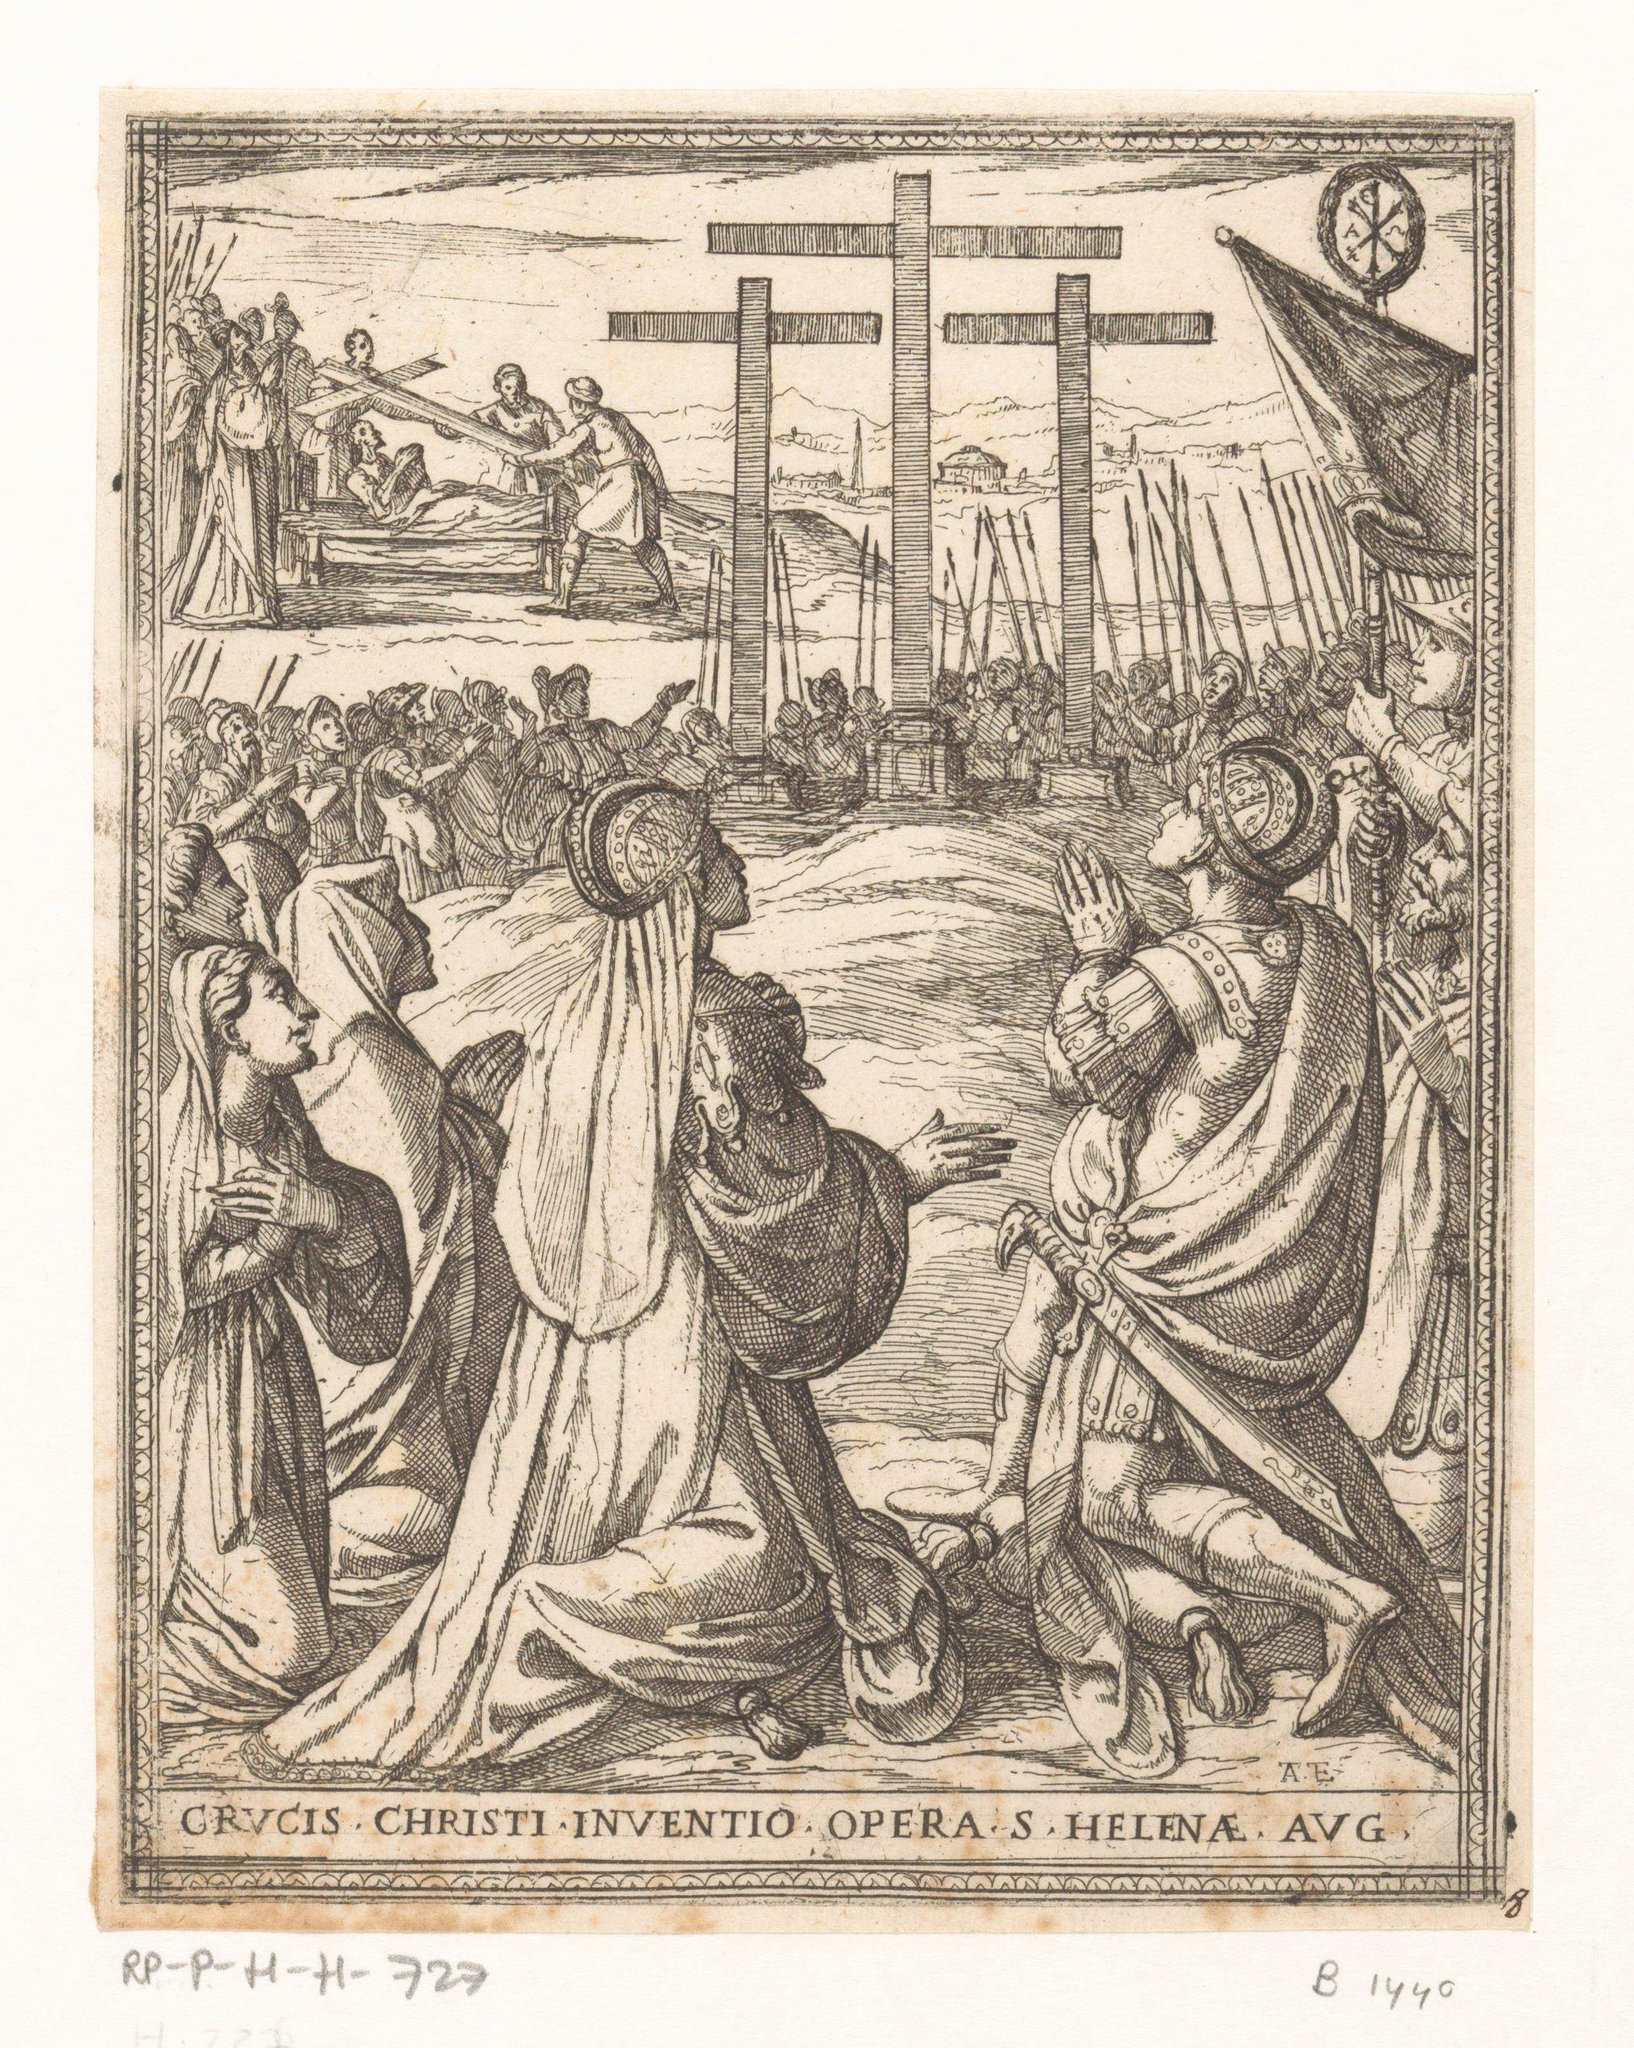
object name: print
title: Crucis Christi inventio opera S Helenae aug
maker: antonio tempesta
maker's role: draughtsman, painter, print maker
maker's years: 1555-1630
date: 1565-1630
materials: paper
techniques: etching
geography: italy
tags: the finding of the true cross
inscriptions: collector's mark: Lugt 11, collector's mark: ‘Hinloopen’, number: ‘8’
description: Constantijn en zijn moeder Helena, omringt door hun leger, knielen voor de drie kruisen op de berg Golgota. Ze hebben het kruis van Christus zojuist ontdekt.